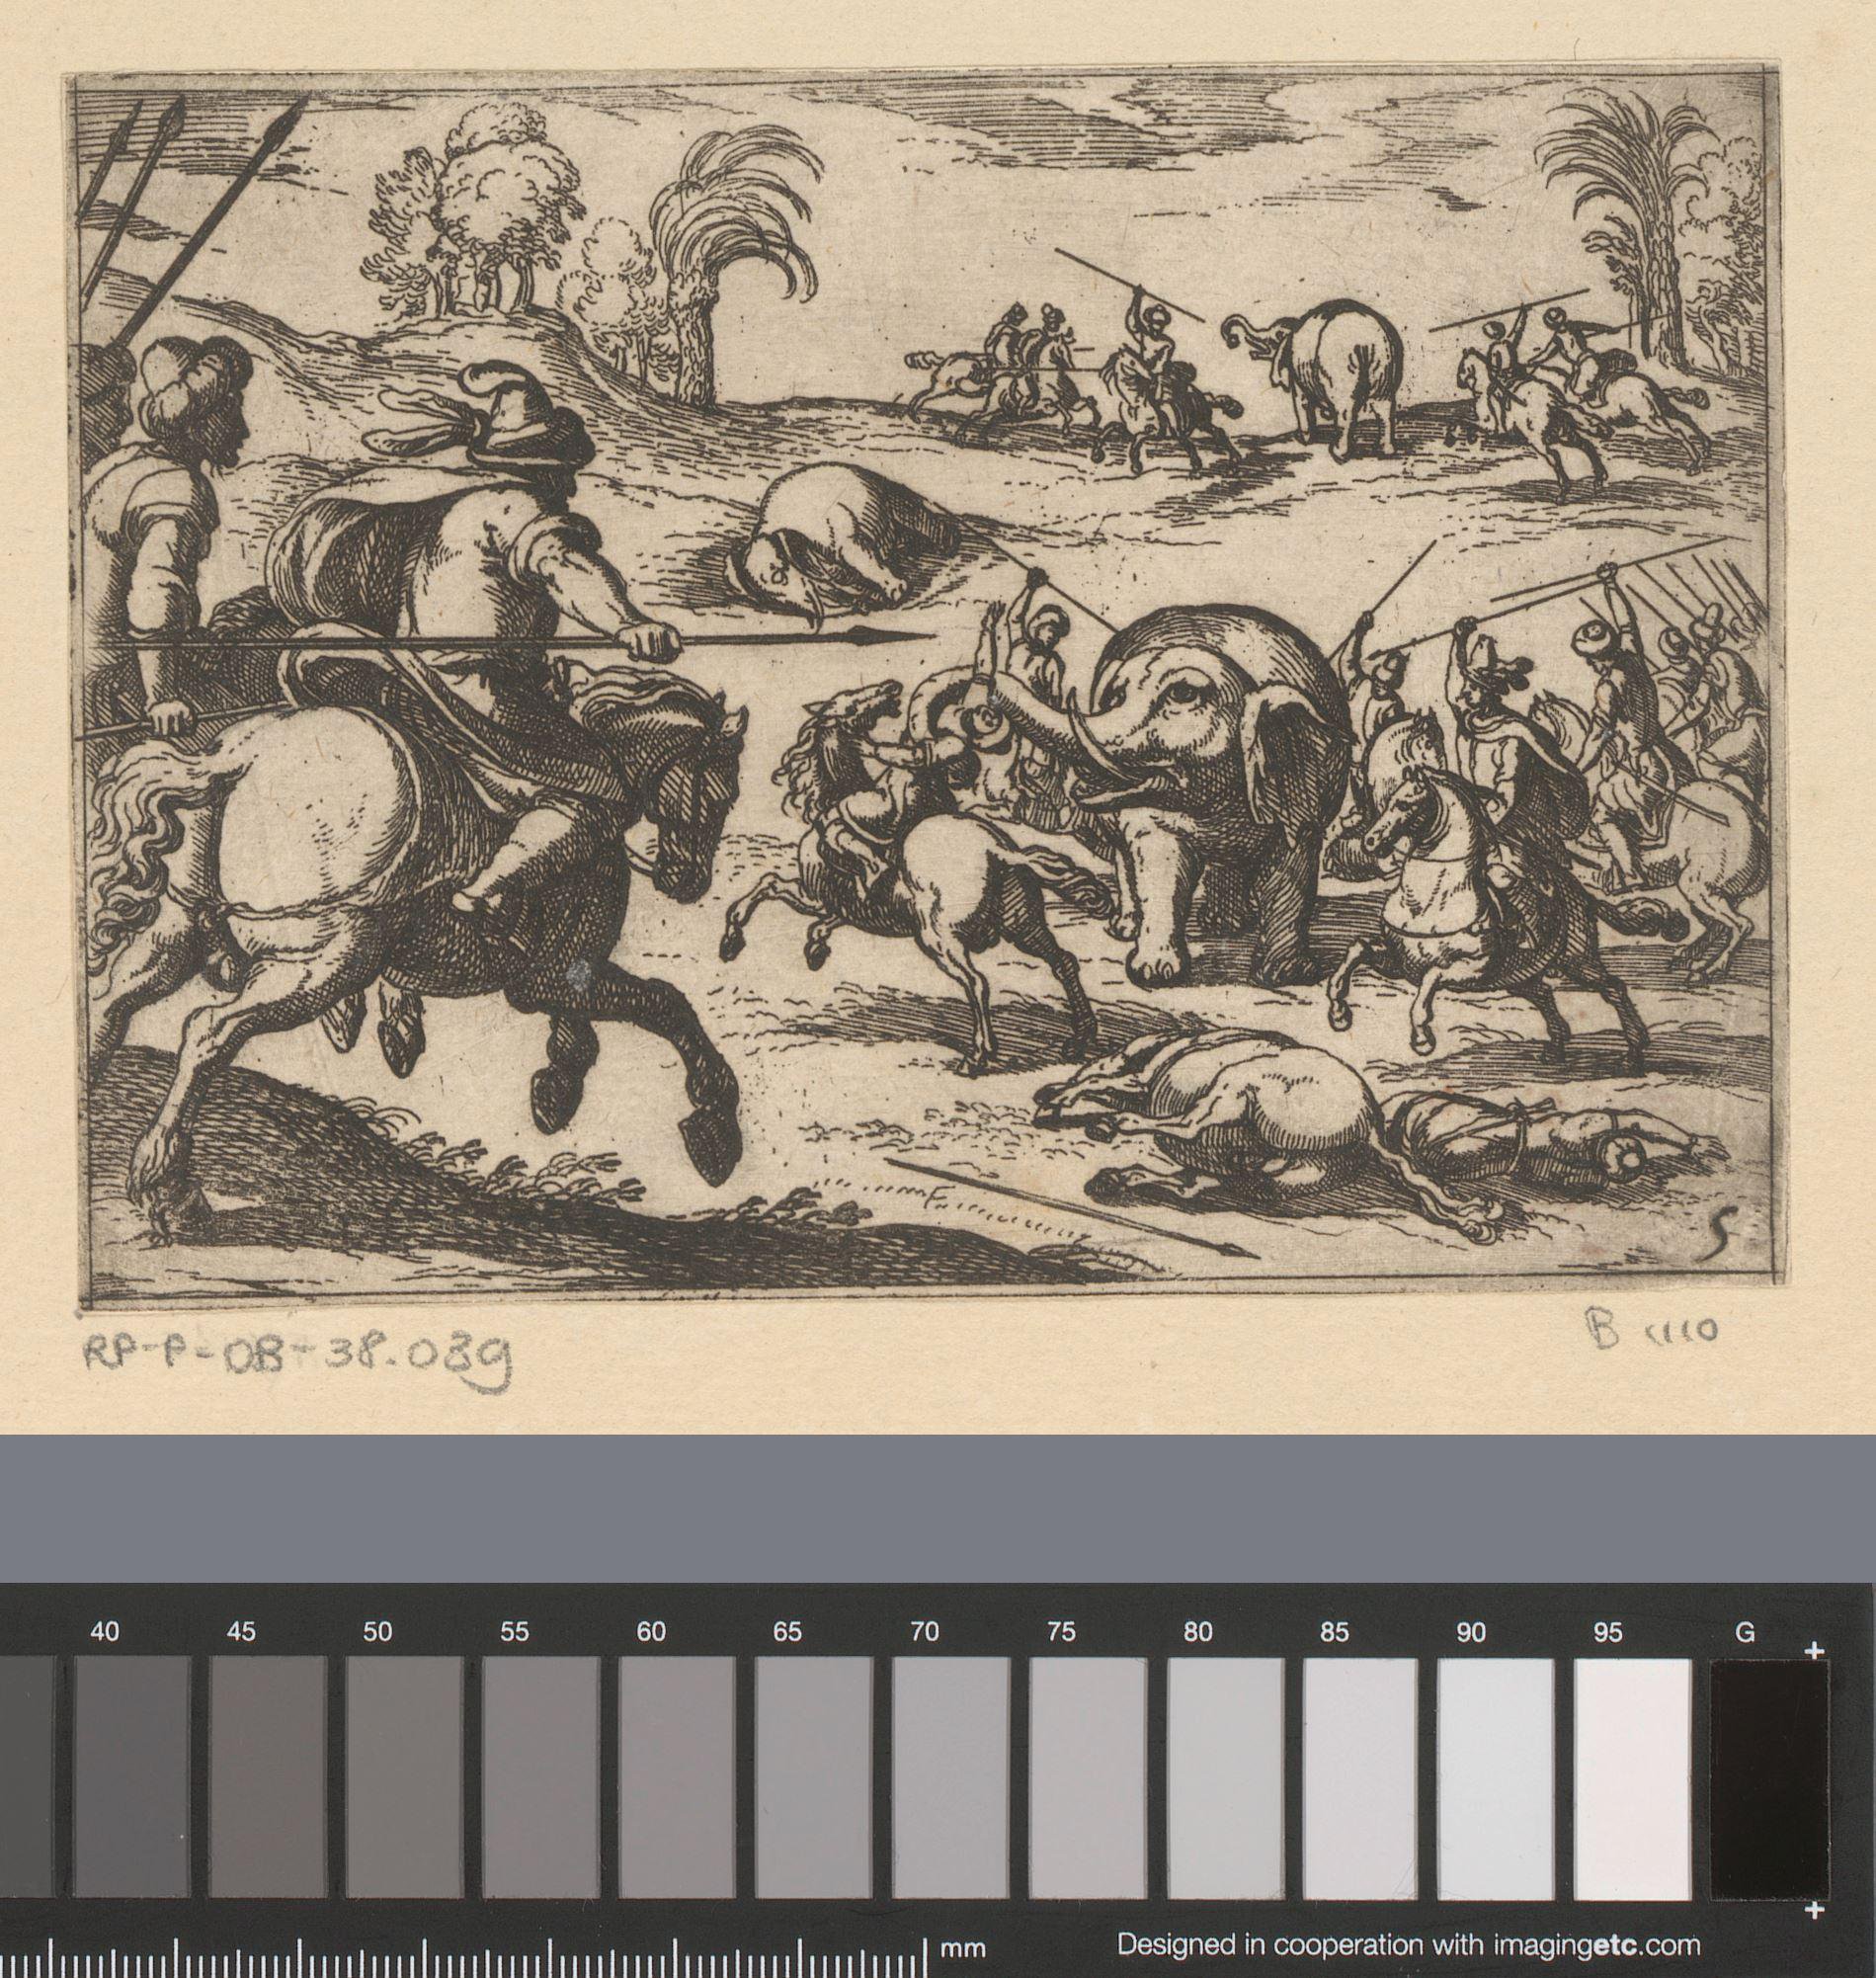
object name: print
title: Jachtscènes (deel 3)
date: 1598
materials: paper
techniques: etching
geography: vatican city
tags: hunter, hunters hunting (n.b.: in 1988-1990 this notation denoted the concept of 43c11421 'hunters resting during the hunt'), trunked animals: elephant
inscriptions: collector's mark: Lugt 240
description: Deze prent maakt deel uit van een reeks van vijftien prenten met jachtscènes (+ opdracht).